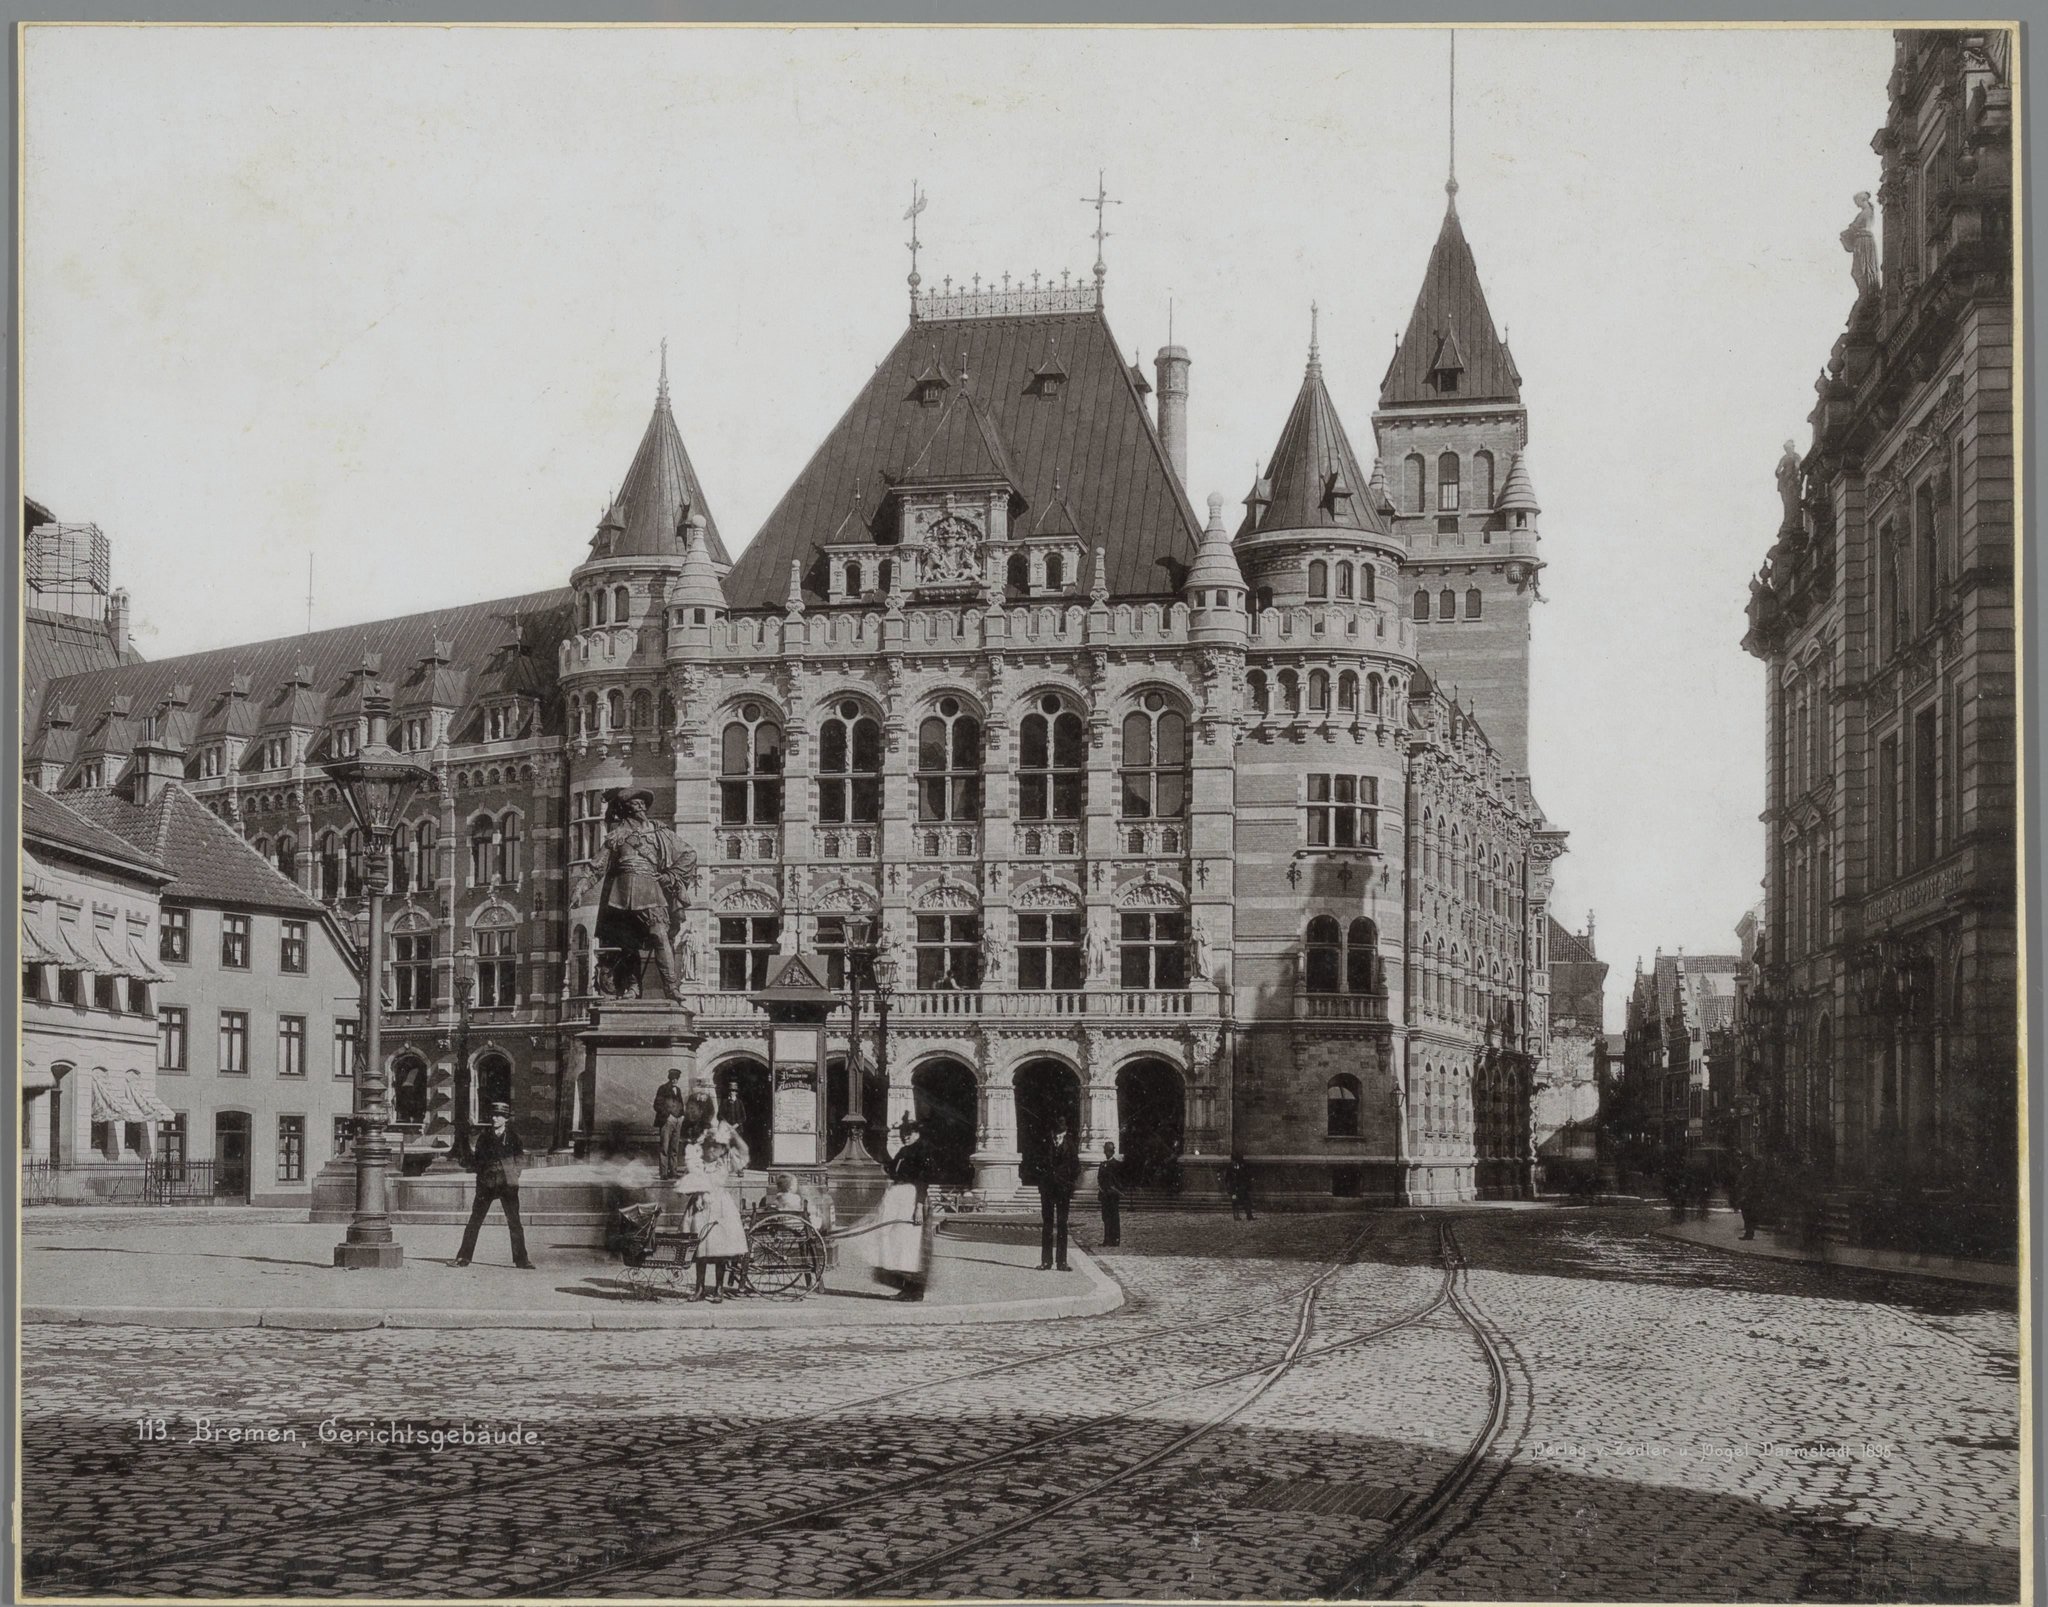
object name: photomechanical print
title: Bremen, Gerichtsgebäude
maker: Anonymous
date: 1895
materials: cardboard, paper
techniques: photograph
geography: darmstadt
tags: court building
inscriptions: title: ‘113. Bremen, Gerichtsgebäude.’, inscription: ‘Verlag. v. Zedler u. Vogel Darmstadt 1895.’